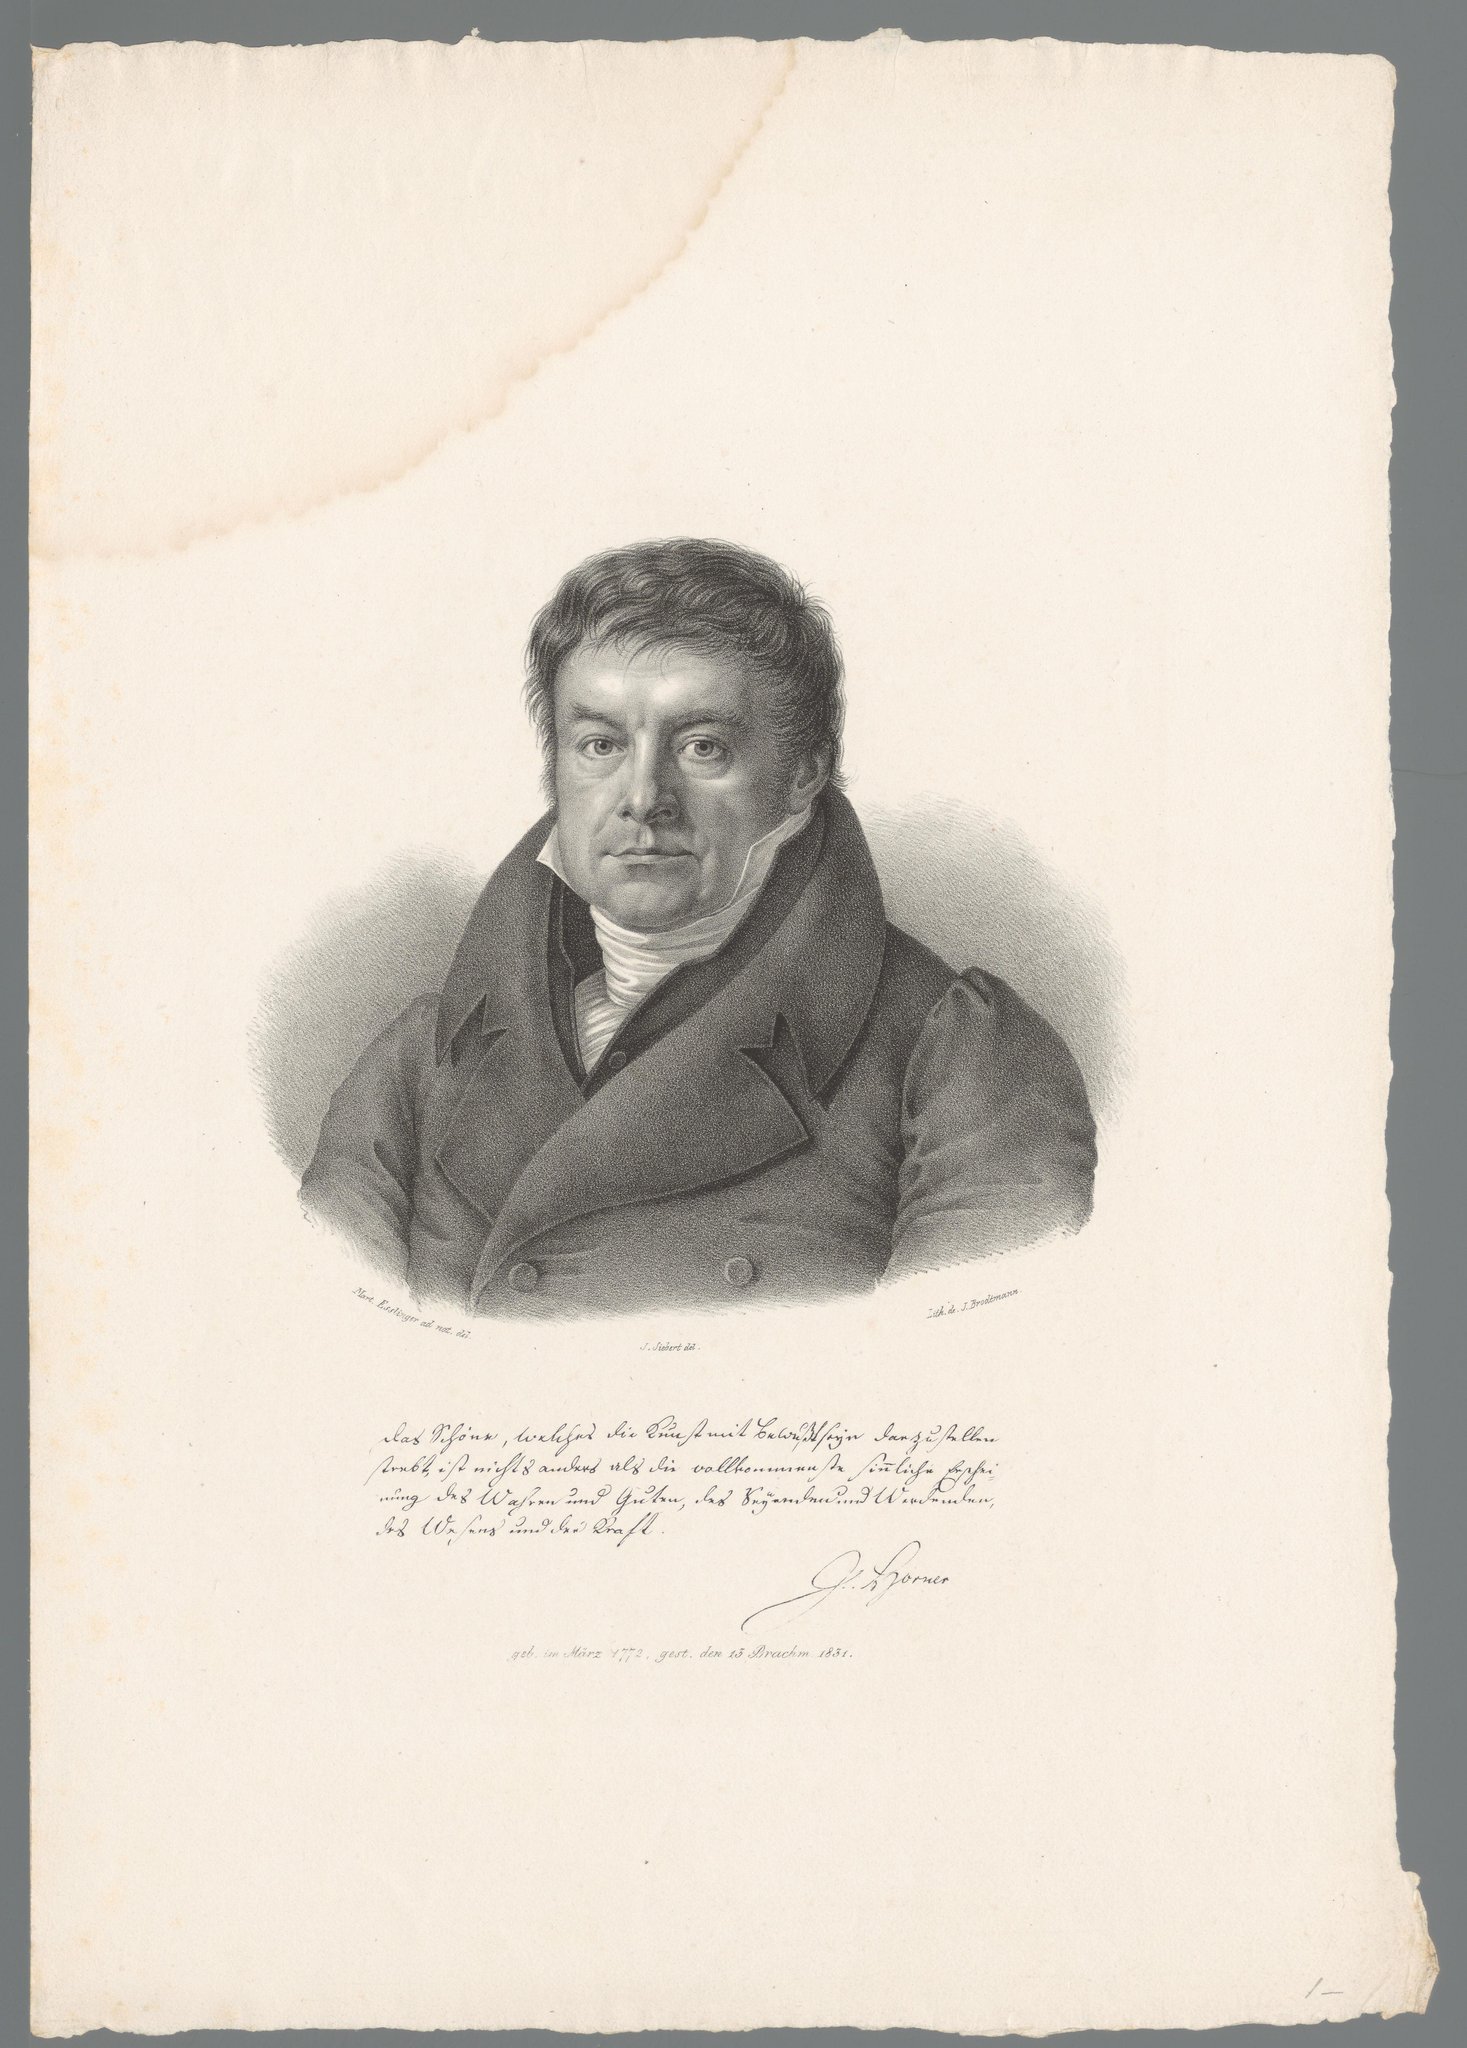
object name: print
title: Portret van Johann Jakob Horner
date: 1831-1875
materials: paper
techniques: lithograph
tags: adult man, historical persons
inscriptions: collector's mark: Lugt 2228